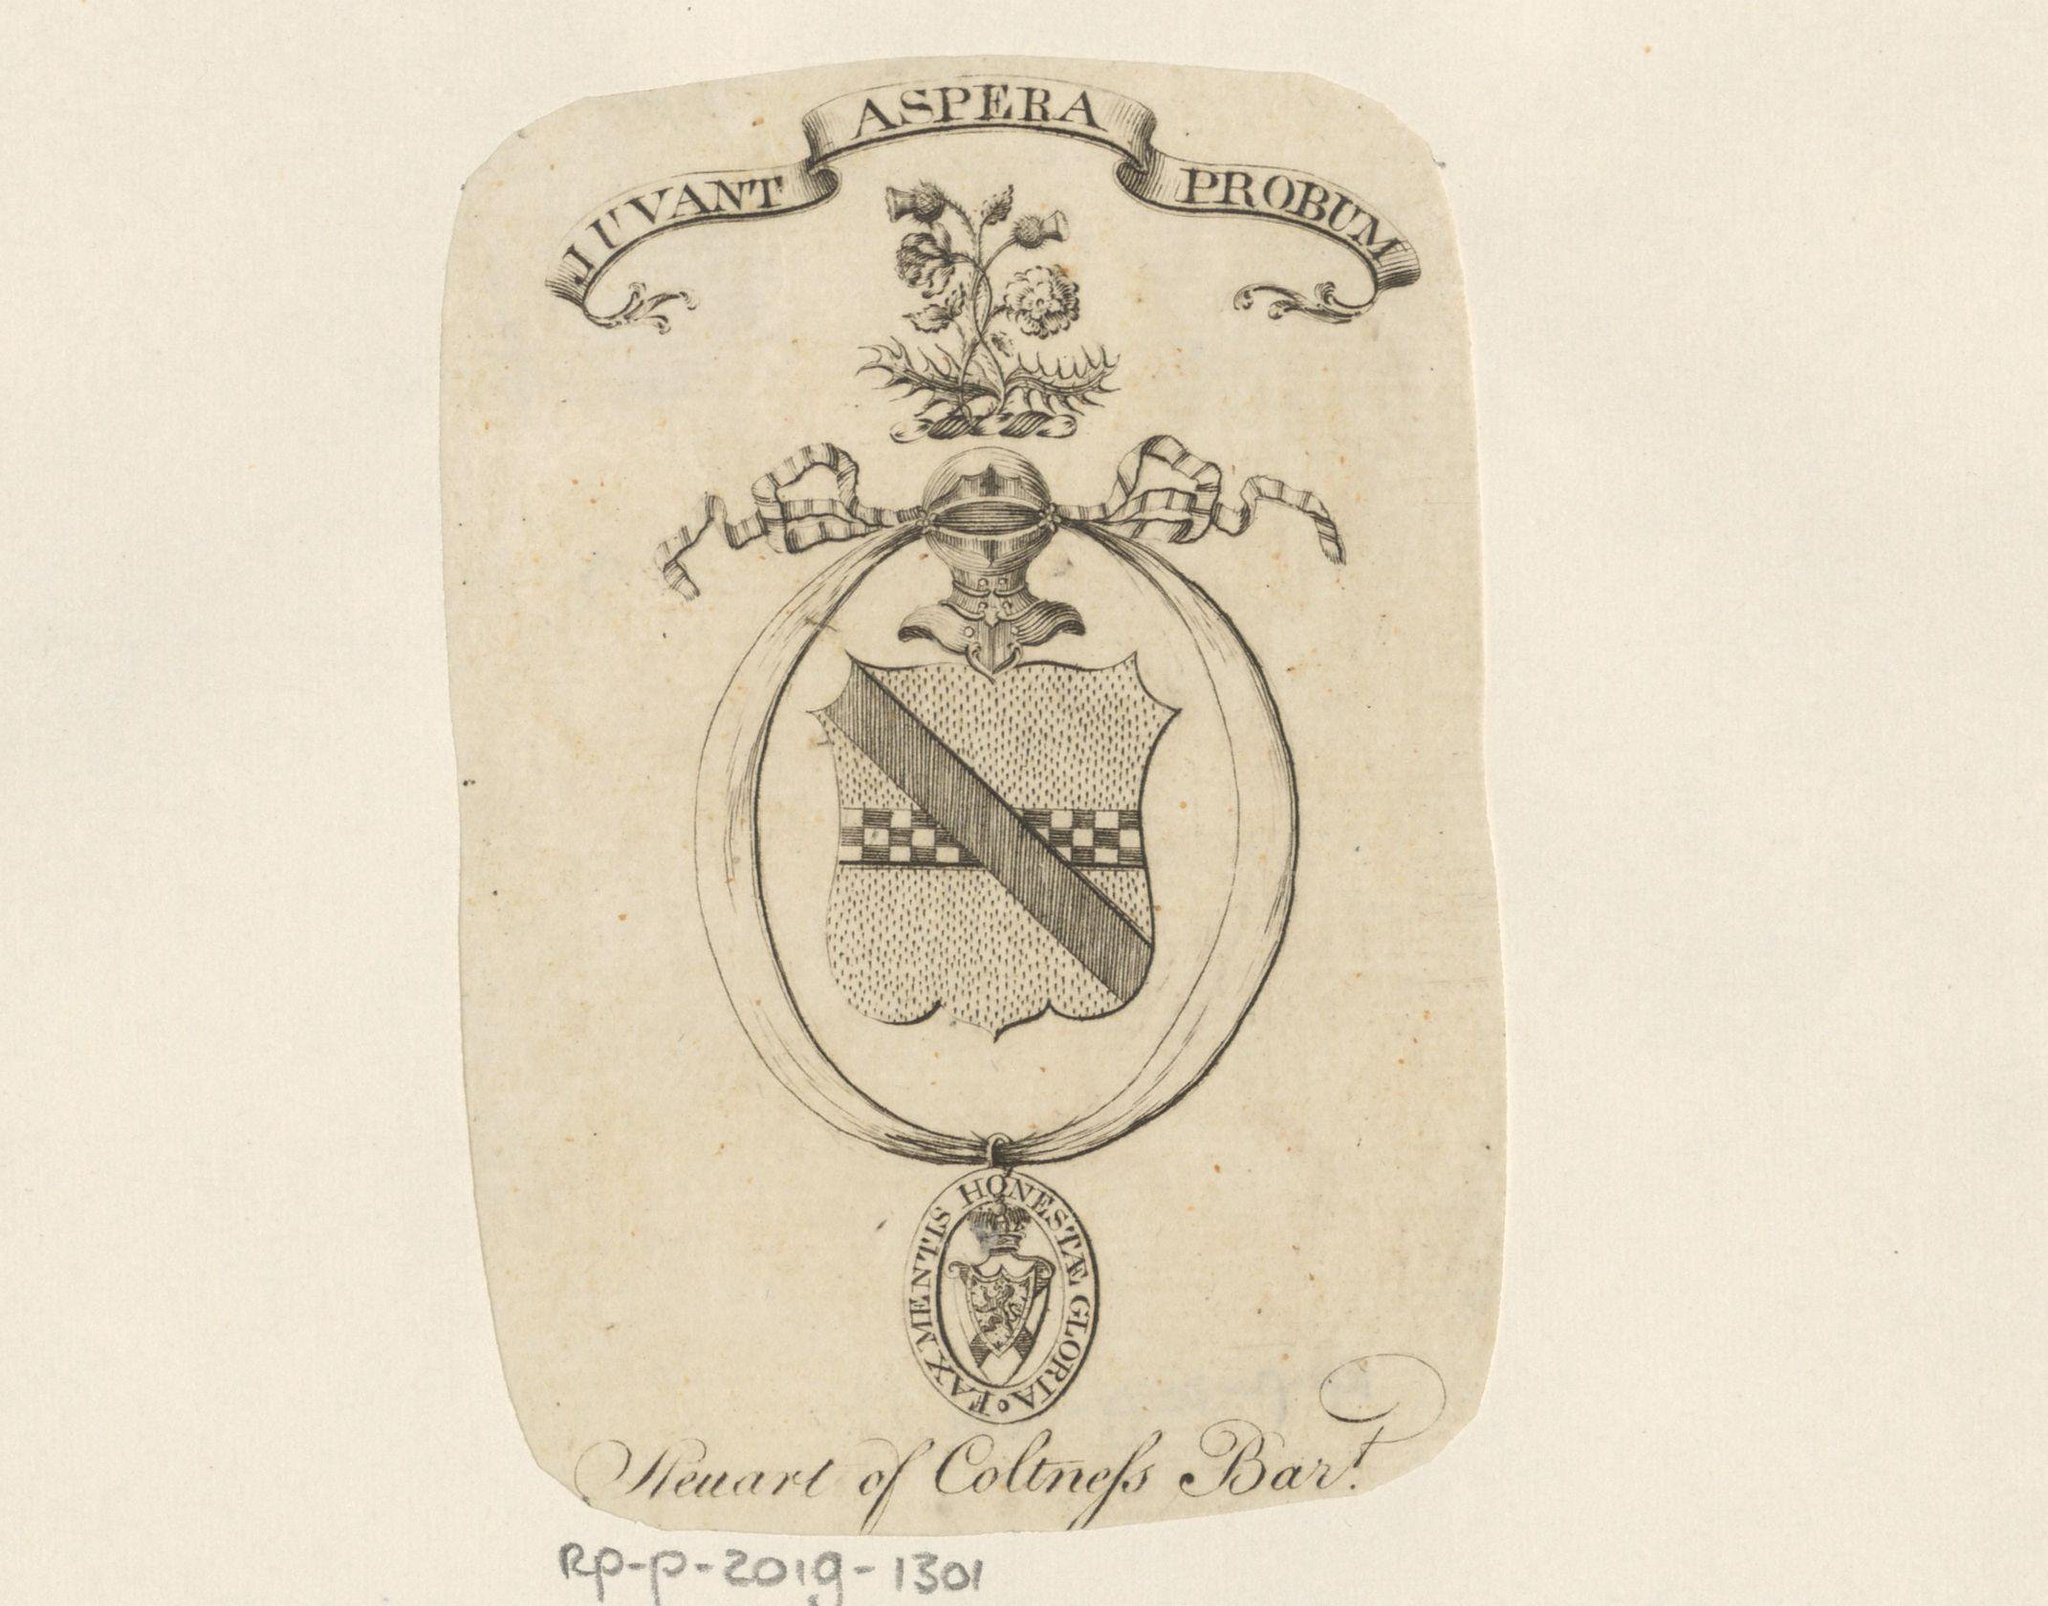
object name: bookplate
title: Ex libris van Steuart of Coltness Bart.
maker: Anonymous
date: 1650-1749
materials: paper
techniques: engraving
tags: armorial bearing, heraldry